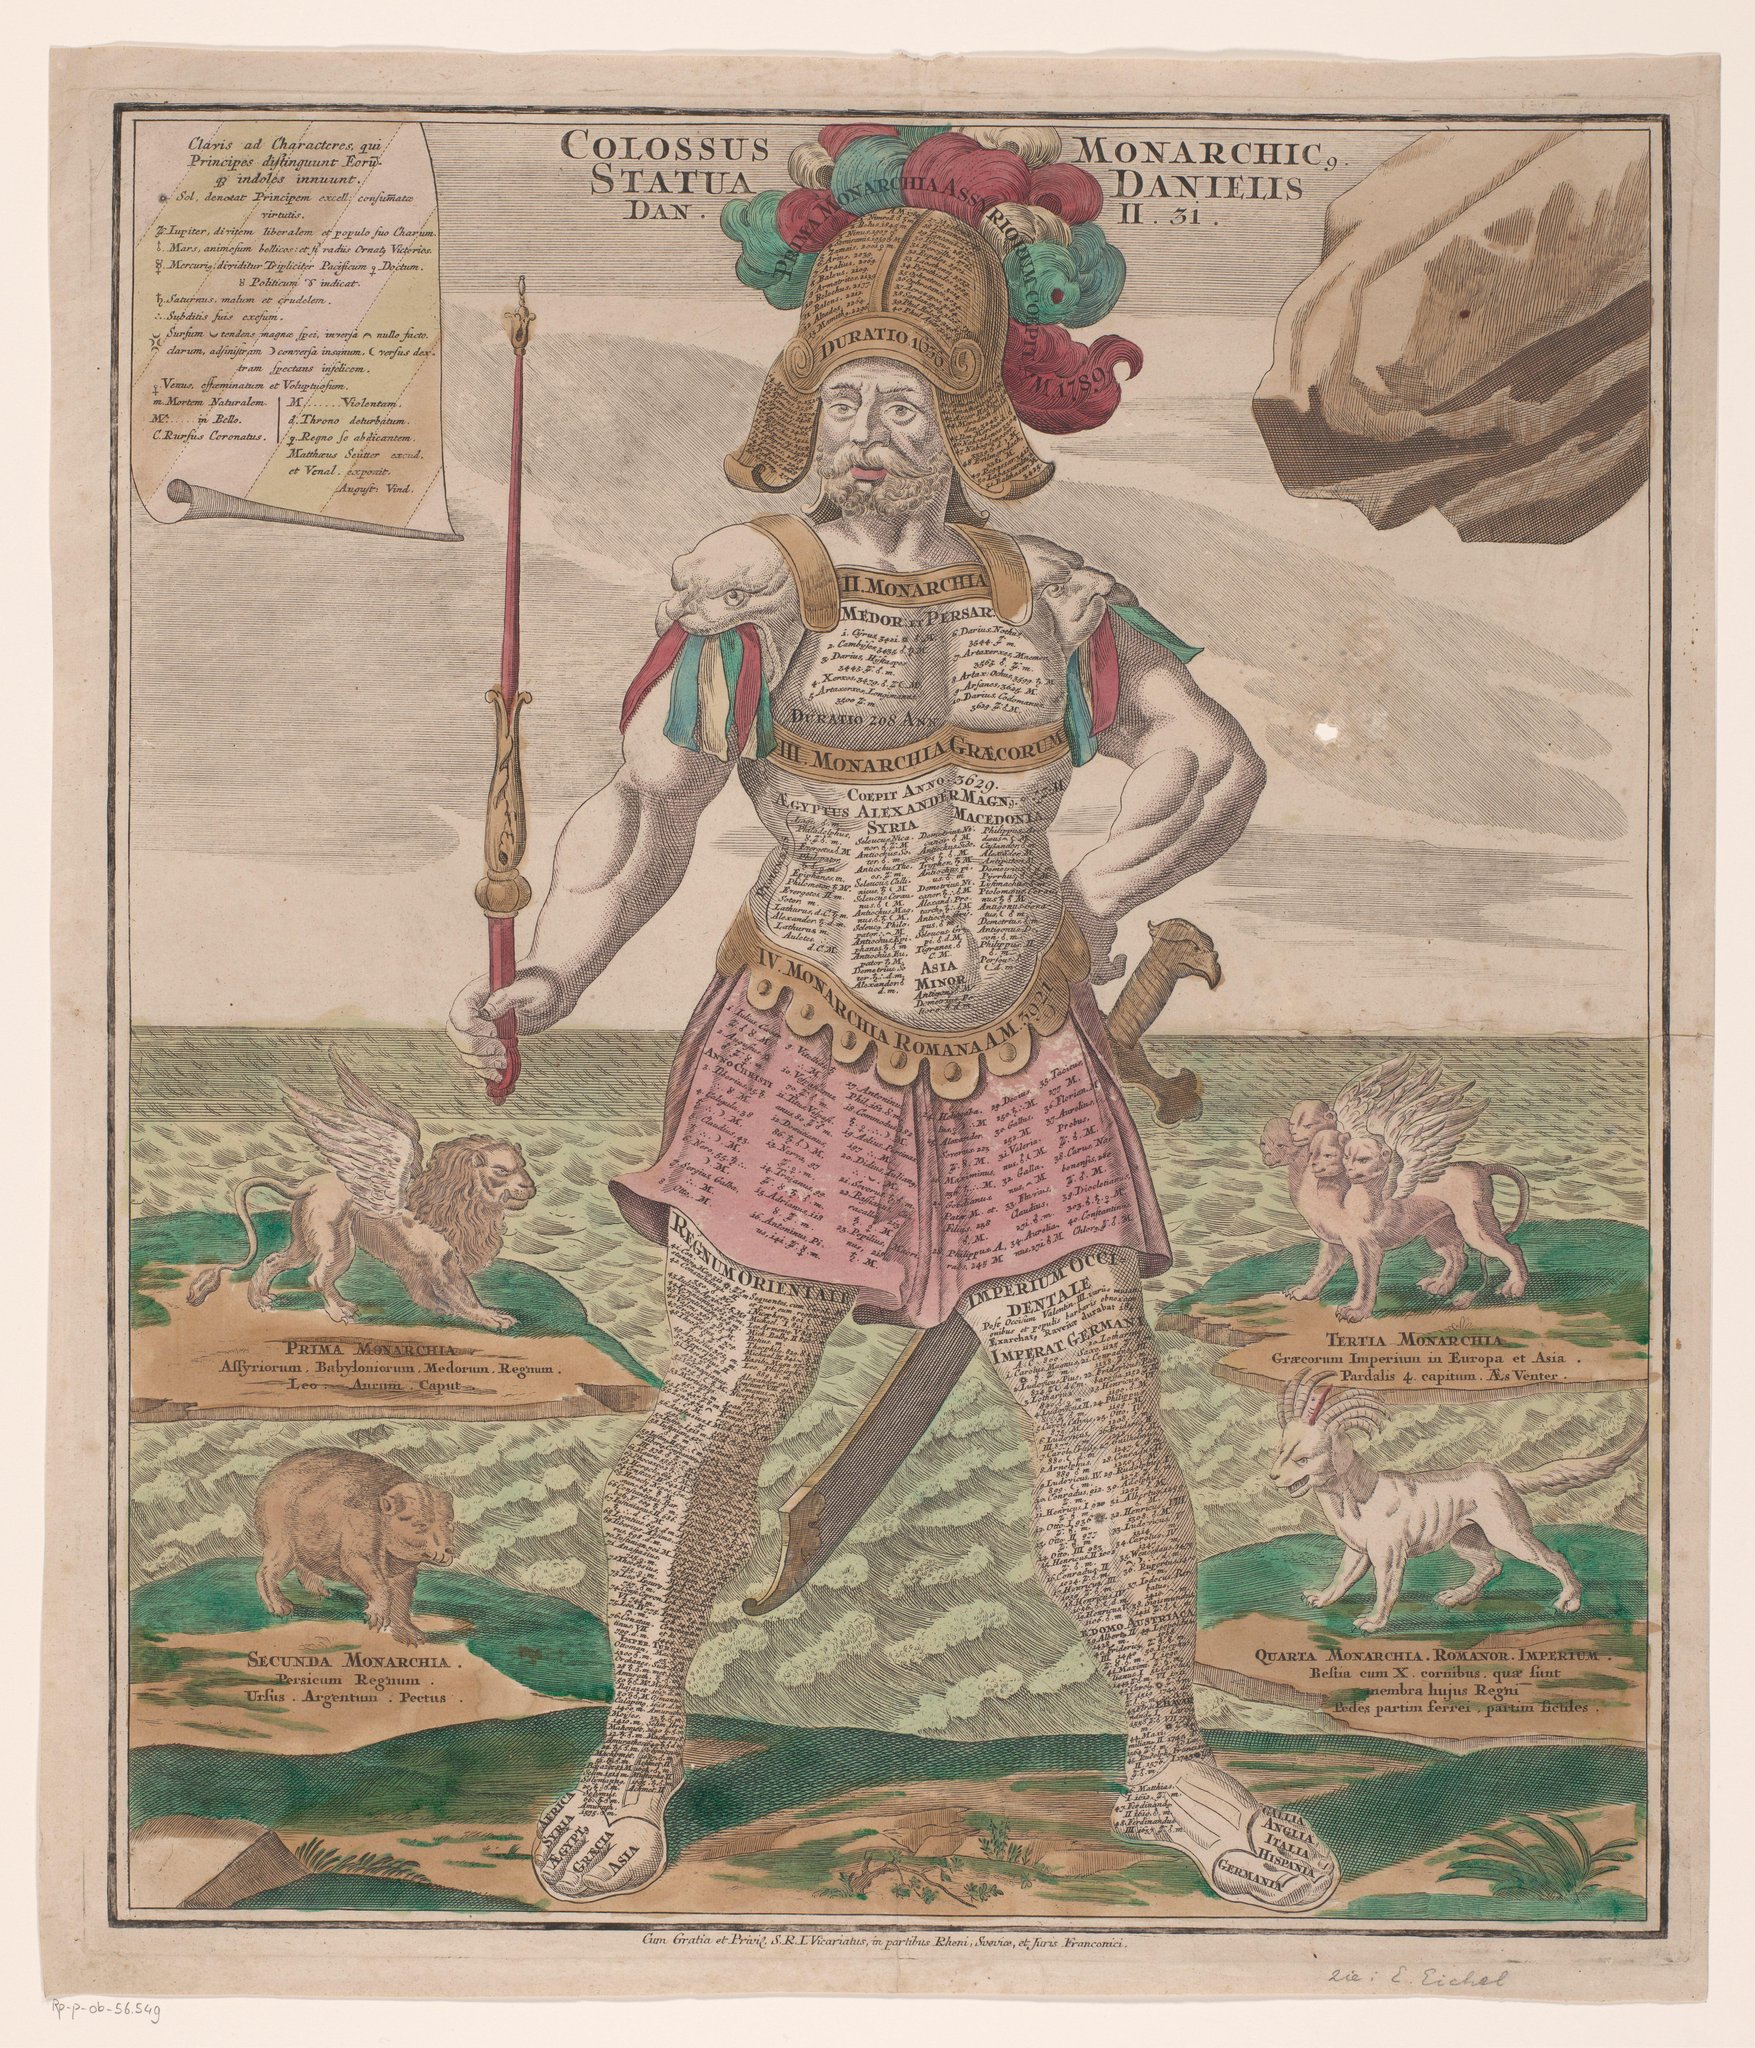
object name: print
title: Colossus Monarchic Statua Danielis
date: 1789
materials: paper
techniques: engraving, etching, hand coloring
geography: germany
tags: daniel (not in biblical context); possible attributes: phrygian bonnet, lion(s), ram, chronology, history, monarchy; 'monarchia mondana' (ripa), mis-shapen animals; monsters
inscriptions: collector's mark: Lugt 2228